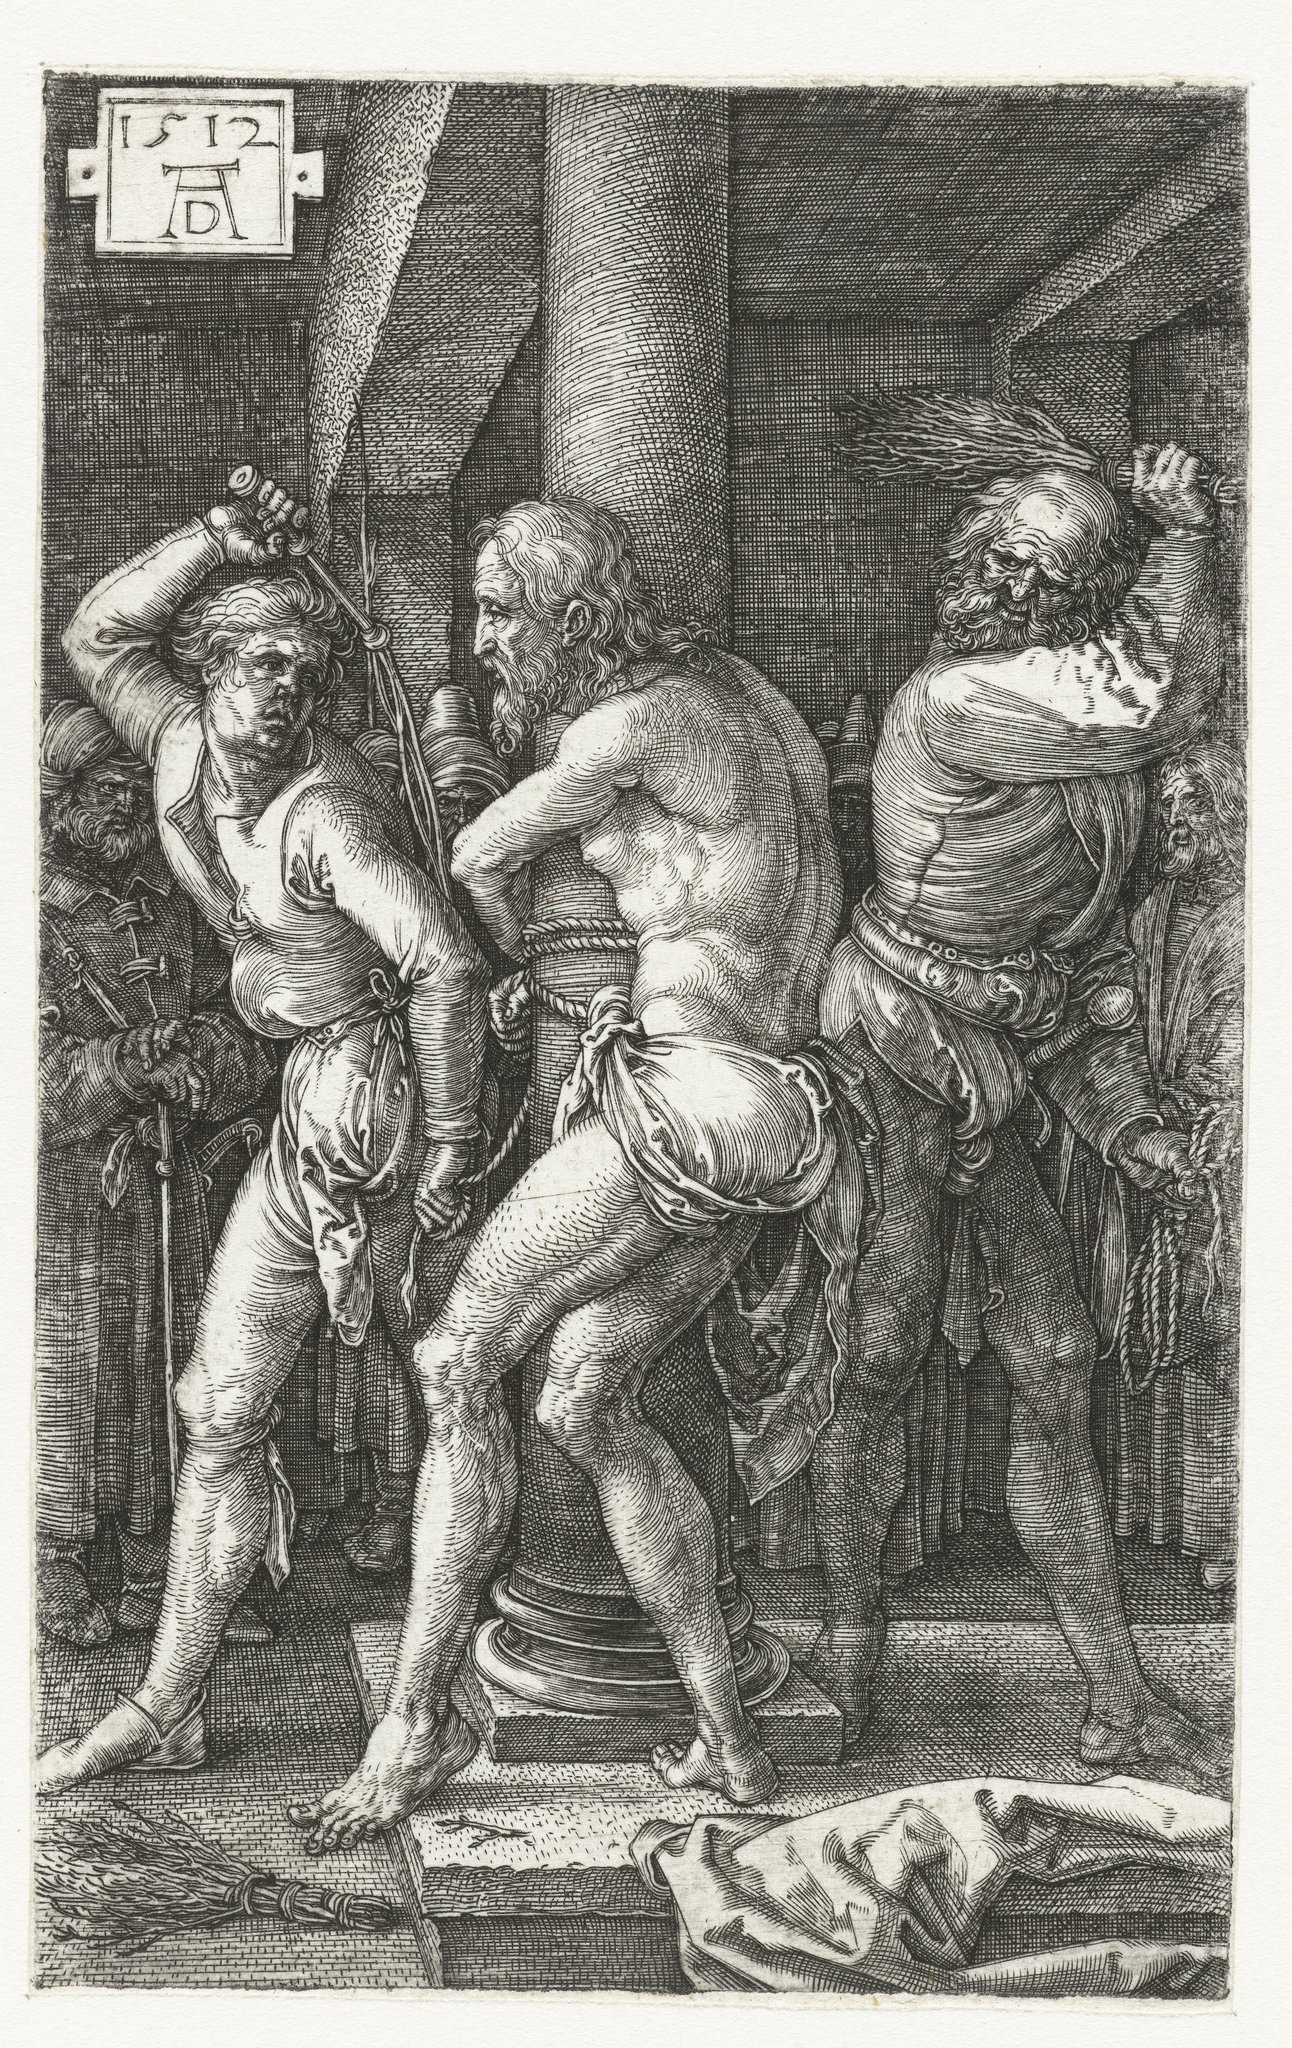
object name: print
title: De geseling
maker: albrecht dürer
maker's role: draughtsman, painter, print maker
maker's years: 1471-1528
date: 1512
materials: paper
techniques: engraving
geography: nuremberg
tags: flagellation by soldiers, christ usually tied to a column (matthew 27:26; mark 15:15; john 19:1)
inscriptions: collector's mark: Lugt 2228a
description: Christus, gebonden aan een pilaar, wordt door twee mannen geslagen met een takkenbos en een gesel. Deze prent is onderdeel van een serie van 16 prenten met scènes uit het Lijdensverhaal.